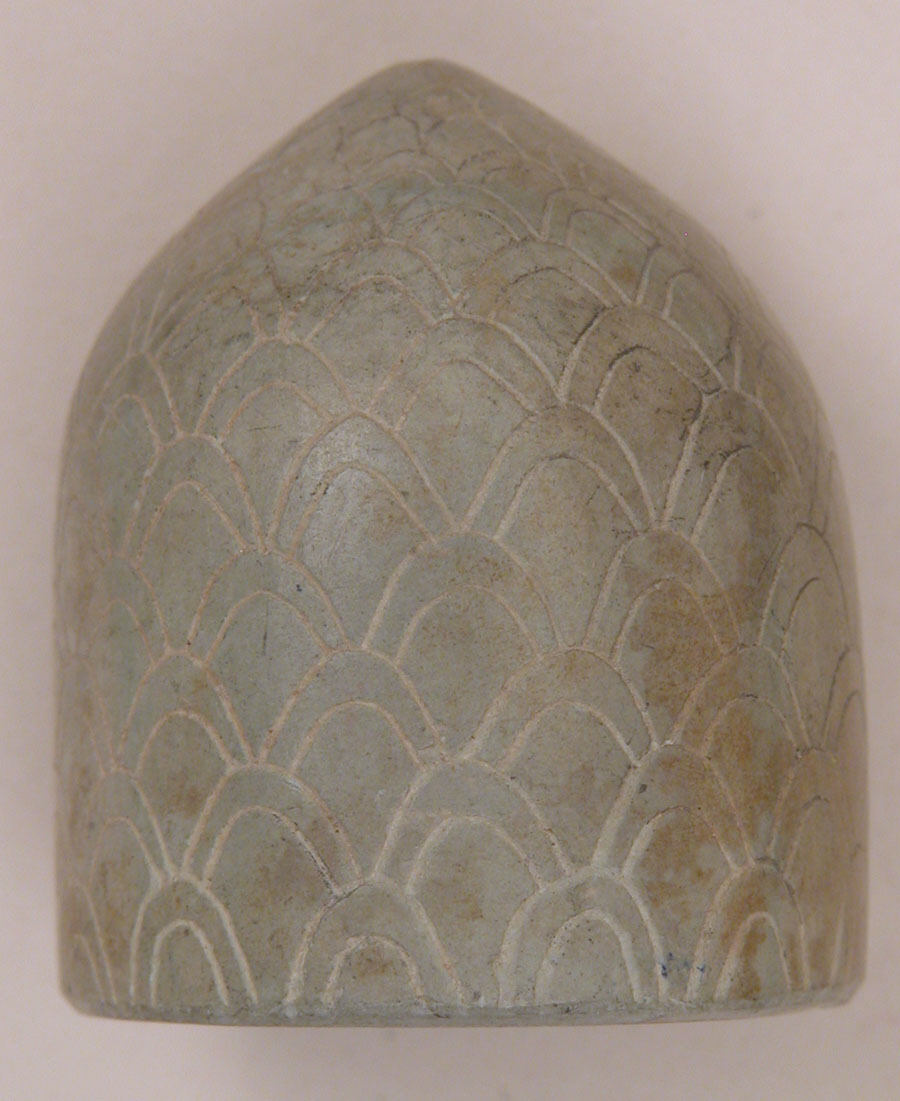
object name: chess or backgammon piece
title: Chess Piece, Pawn or Backgammon Piece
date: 1601-1800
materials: stone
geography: india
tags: chess